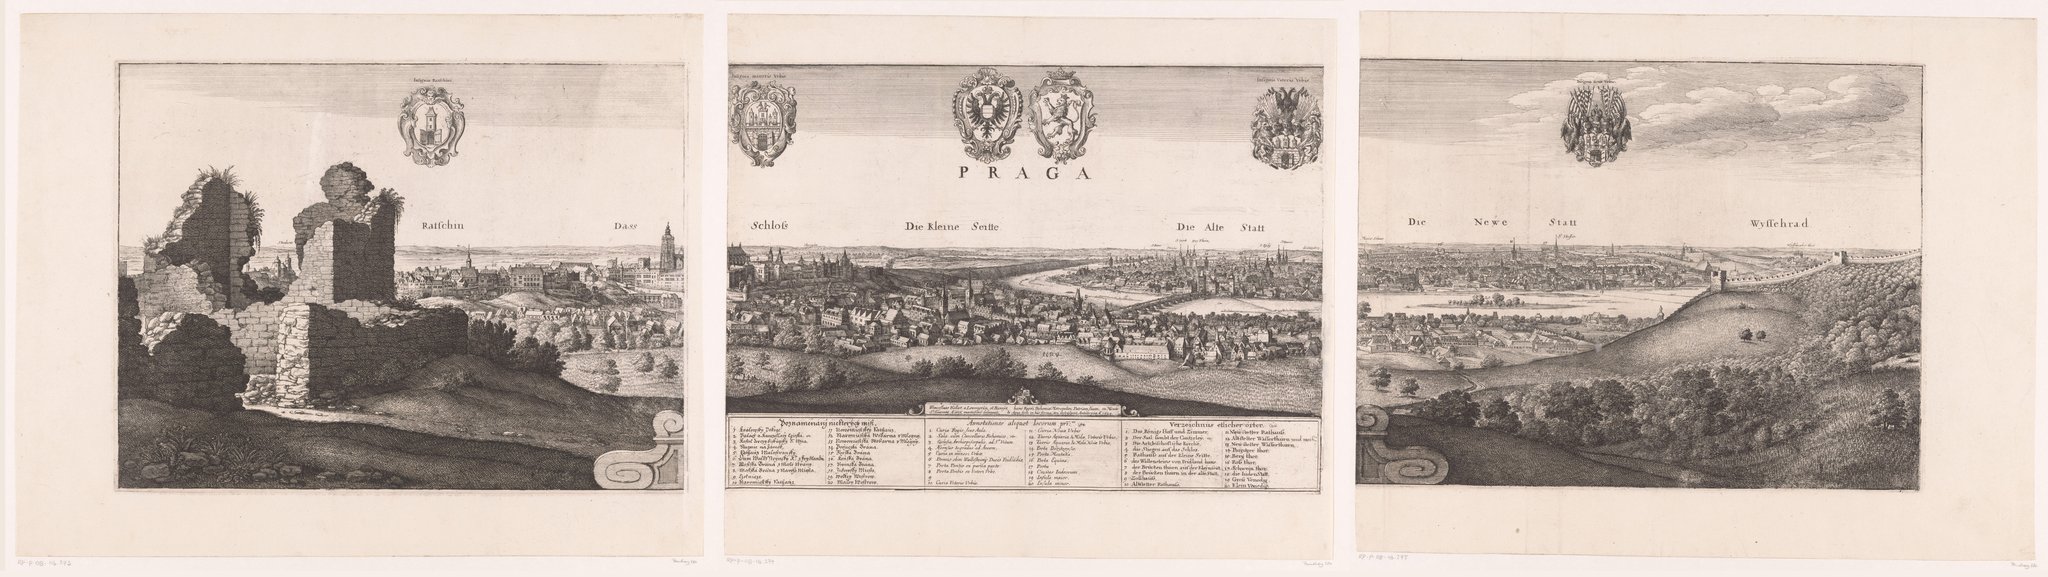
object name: print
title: Praga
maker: wenceslaus hollar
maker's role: draughtsman, print maker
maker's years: 1607-1677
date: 1649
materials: paper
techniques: etching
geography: germany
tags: maps of cities, coat of arms (as symbol of the state, etc.) (+ province; provincial), prospect of city, town panorama, silhouette of city, prague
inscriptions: collector's mark: Lugt 240, collector's mark: Lugt 2228, annotation: ‘Praga’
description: Gezicht op de stad Praag bestaande uit drie delen. In de voorgrond van het linkerdeel een ruïne. Het middelste deel is een gezicht op de stad. Het rechterdeel is een uitzicht op de stadsmuren van Praag. De belangrijkste stadsdelen zijn aangeduid in de horizon over de gehele breedte. In de marge daarboven zes wapenschilden. In het middelste deel een legenda in het Tsjechisch, Latijn en Duits.